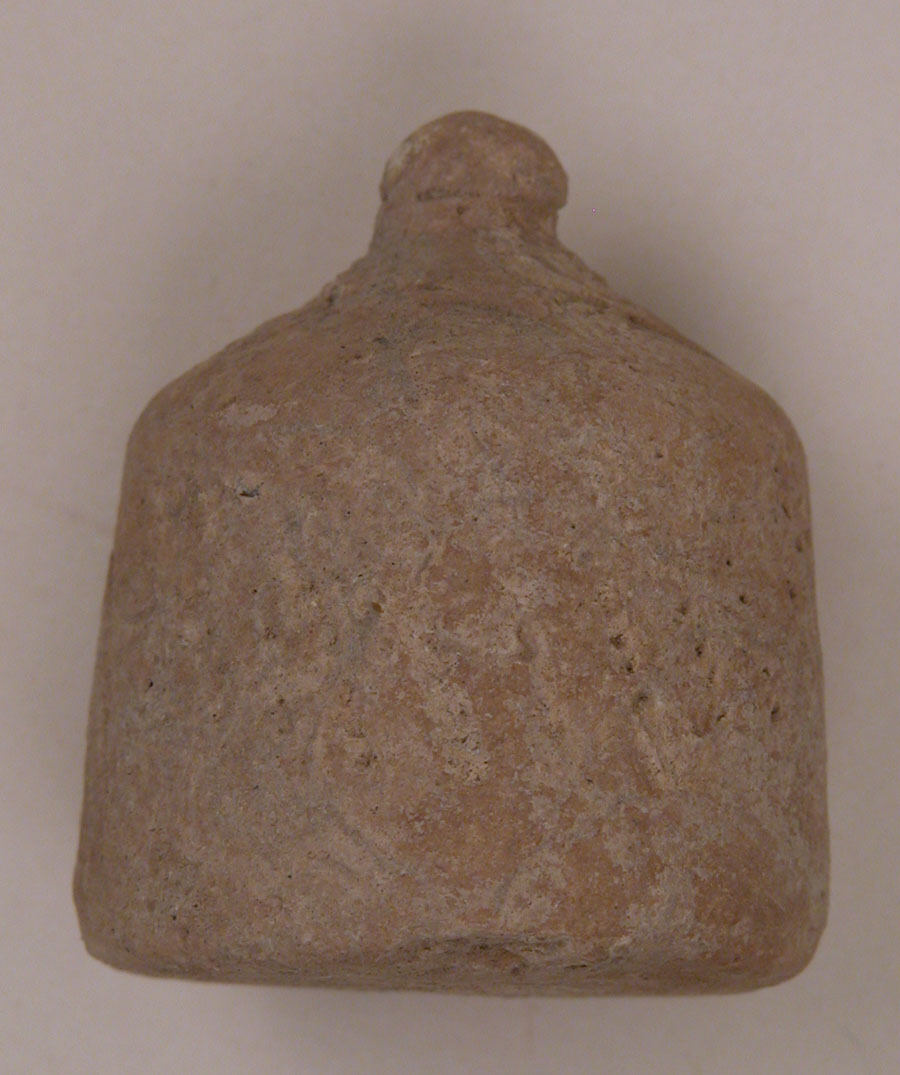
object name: chess piece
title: Chess Piece, Probably a Pawn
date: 701-1100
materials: earthenware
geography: western islamic lands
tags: chess,games